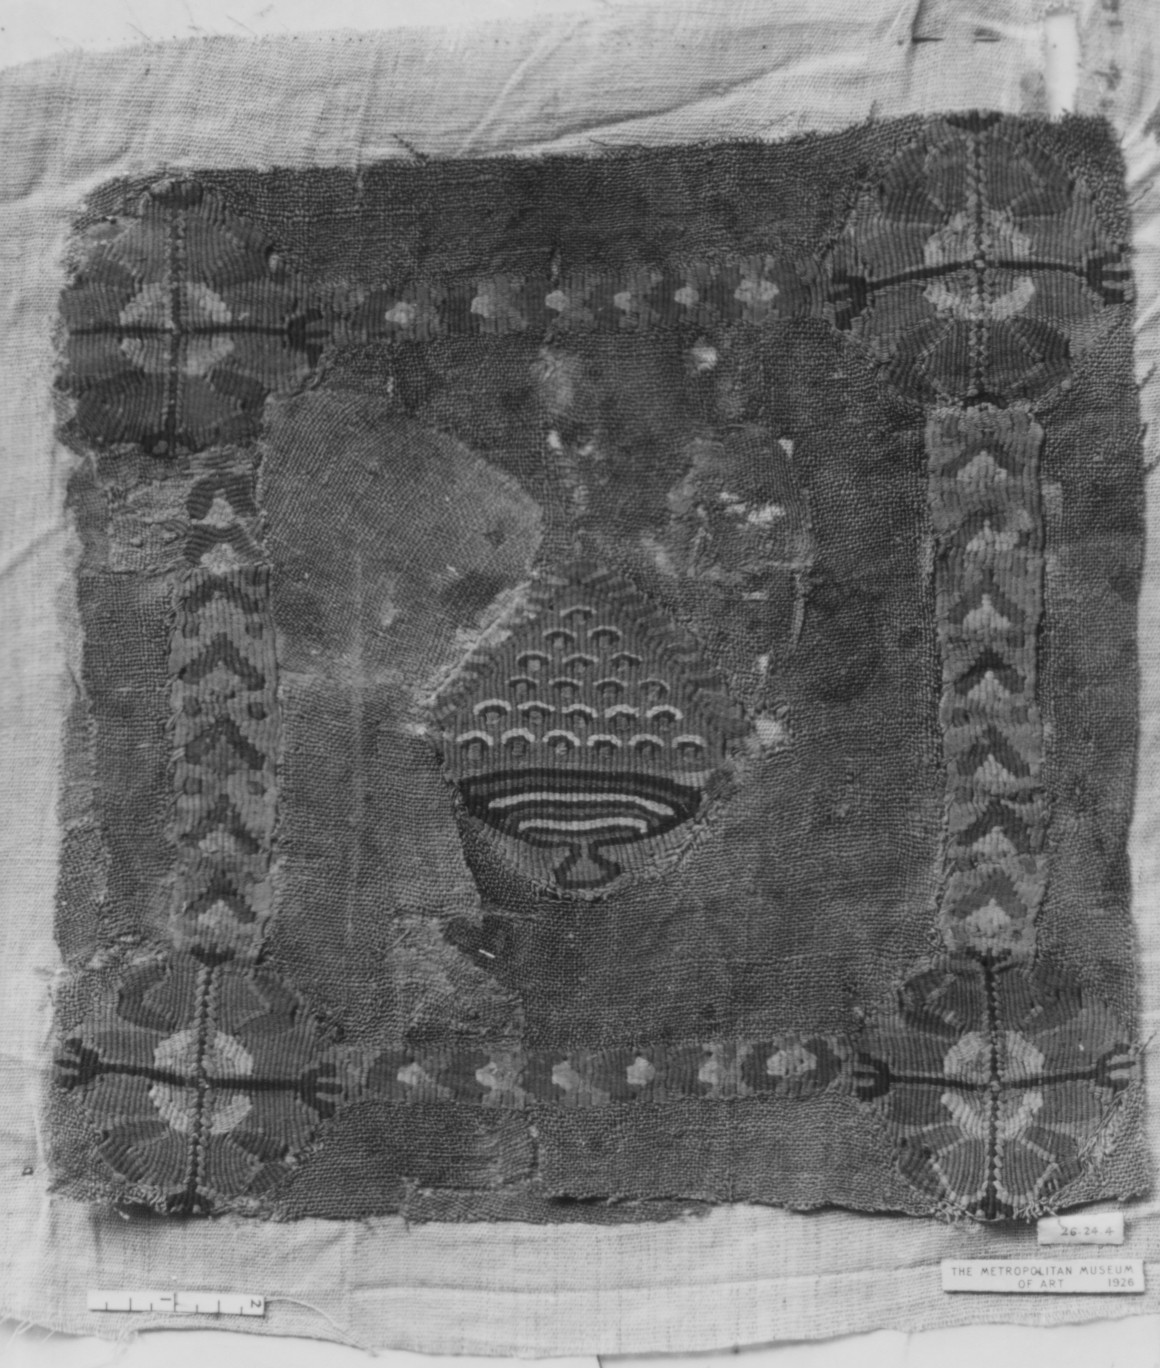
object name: fragment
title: Textile Fragment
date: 401-500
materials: linen, wool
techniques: weave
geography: egypt